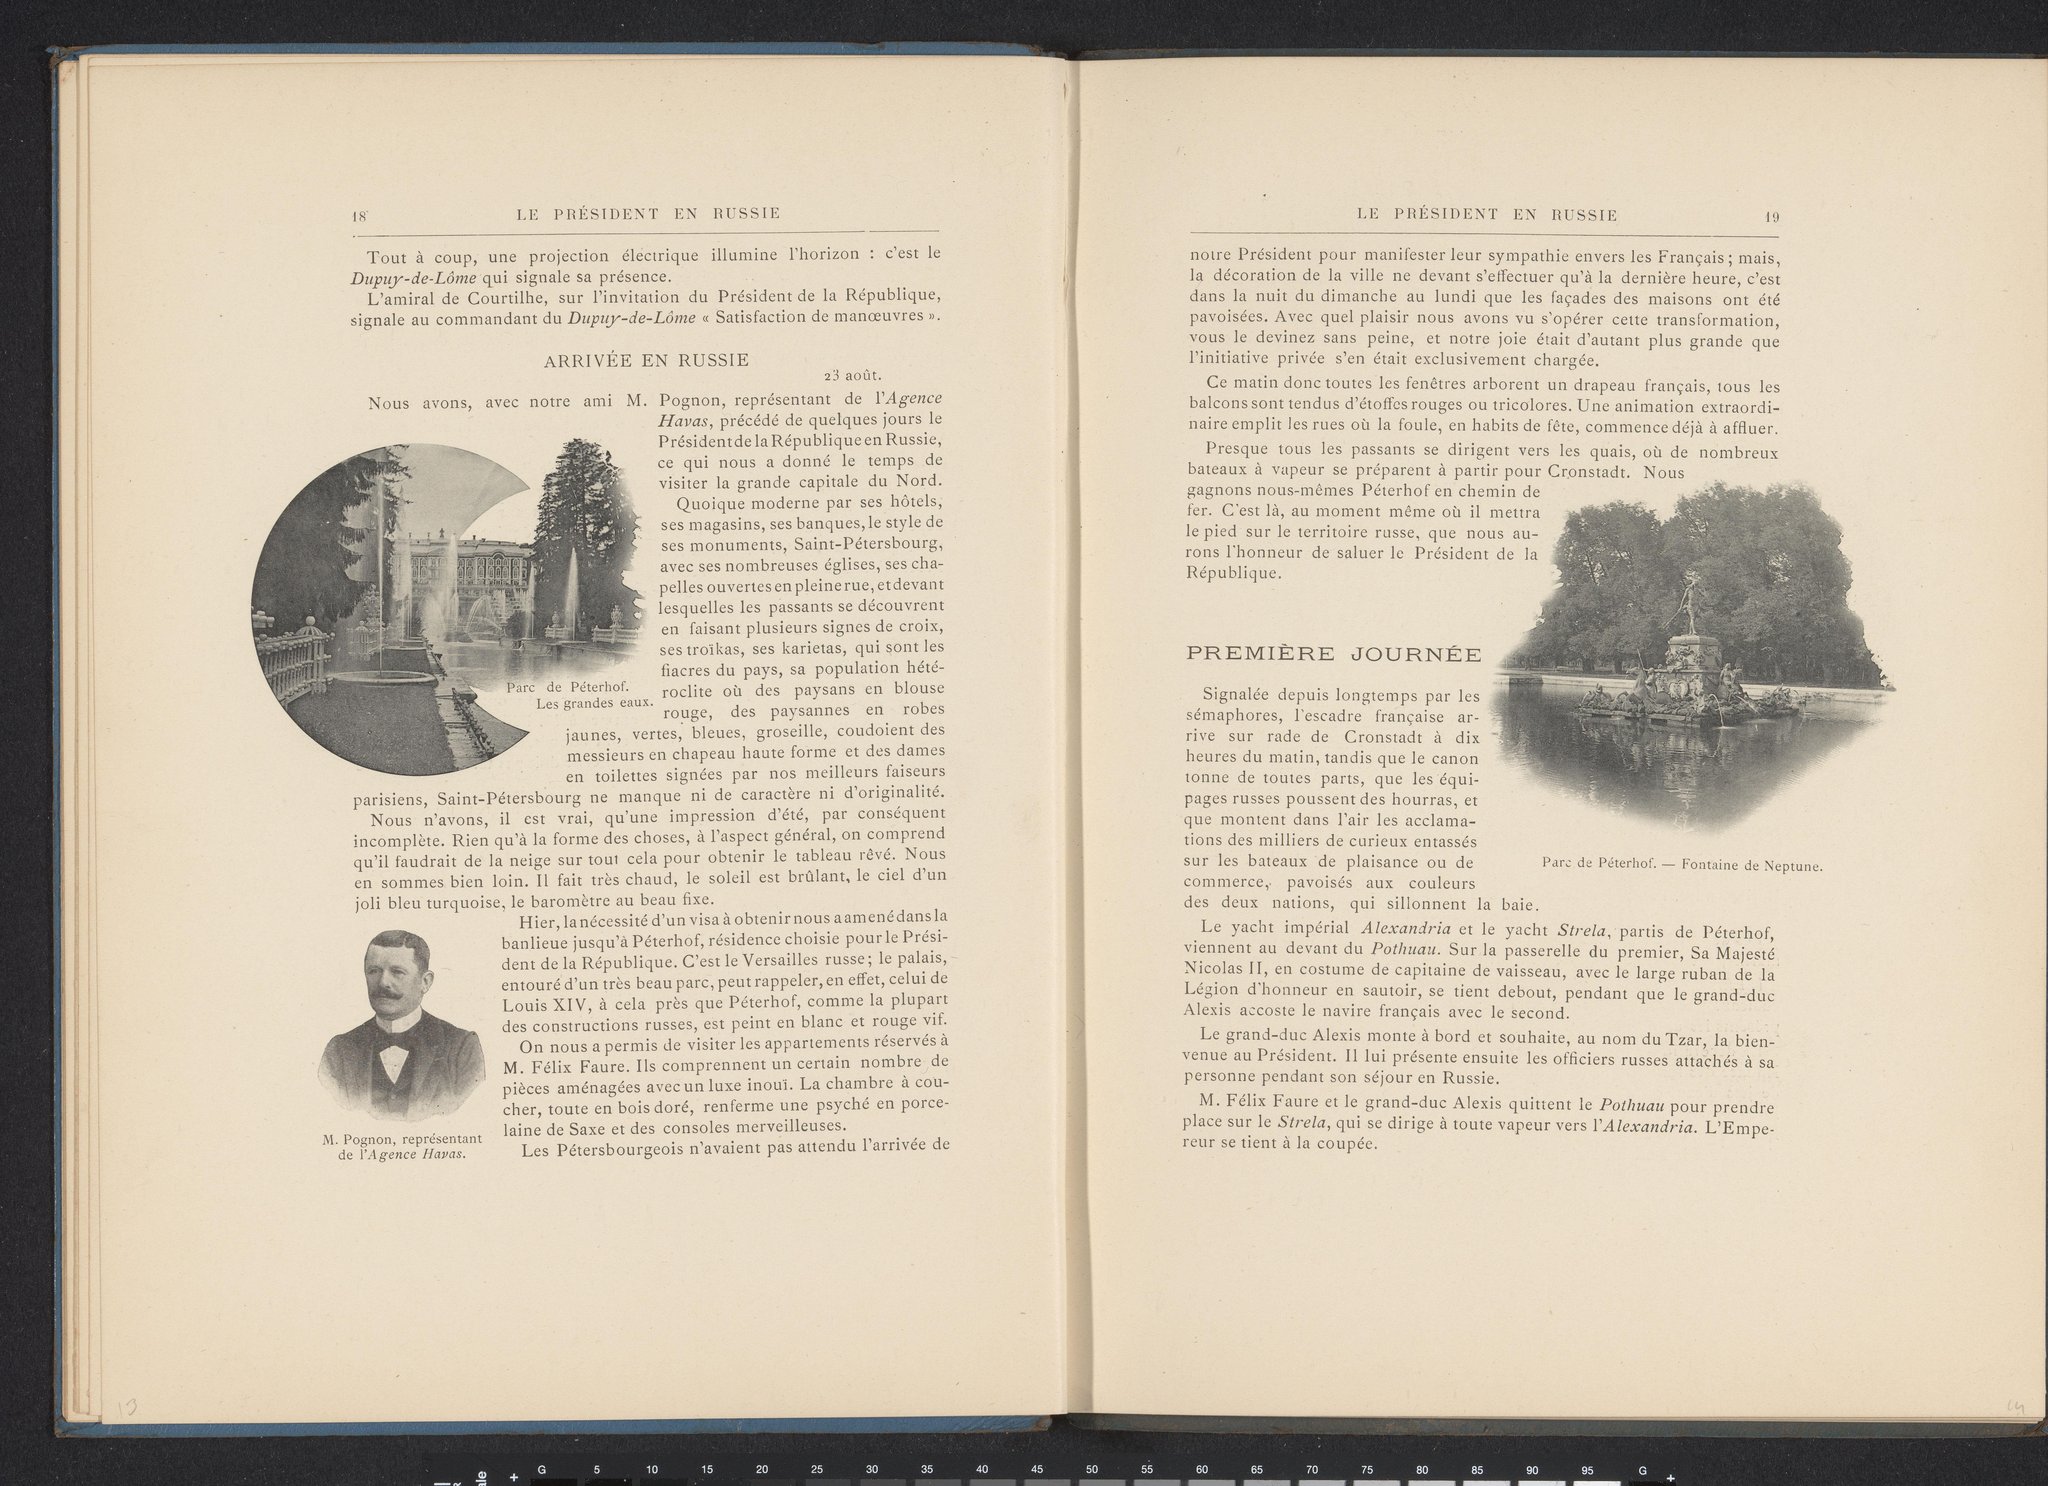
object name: photomechanical print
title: Neptunusfontein in het park van het Paleizencomplex van Peterhof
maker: Anonymous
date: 1897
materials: paper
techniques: photograph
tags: (story of) neptune (poseidon), garden fountain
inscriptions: inscription: ‘Parc de Péterhof.- Fontaine de Neptune’